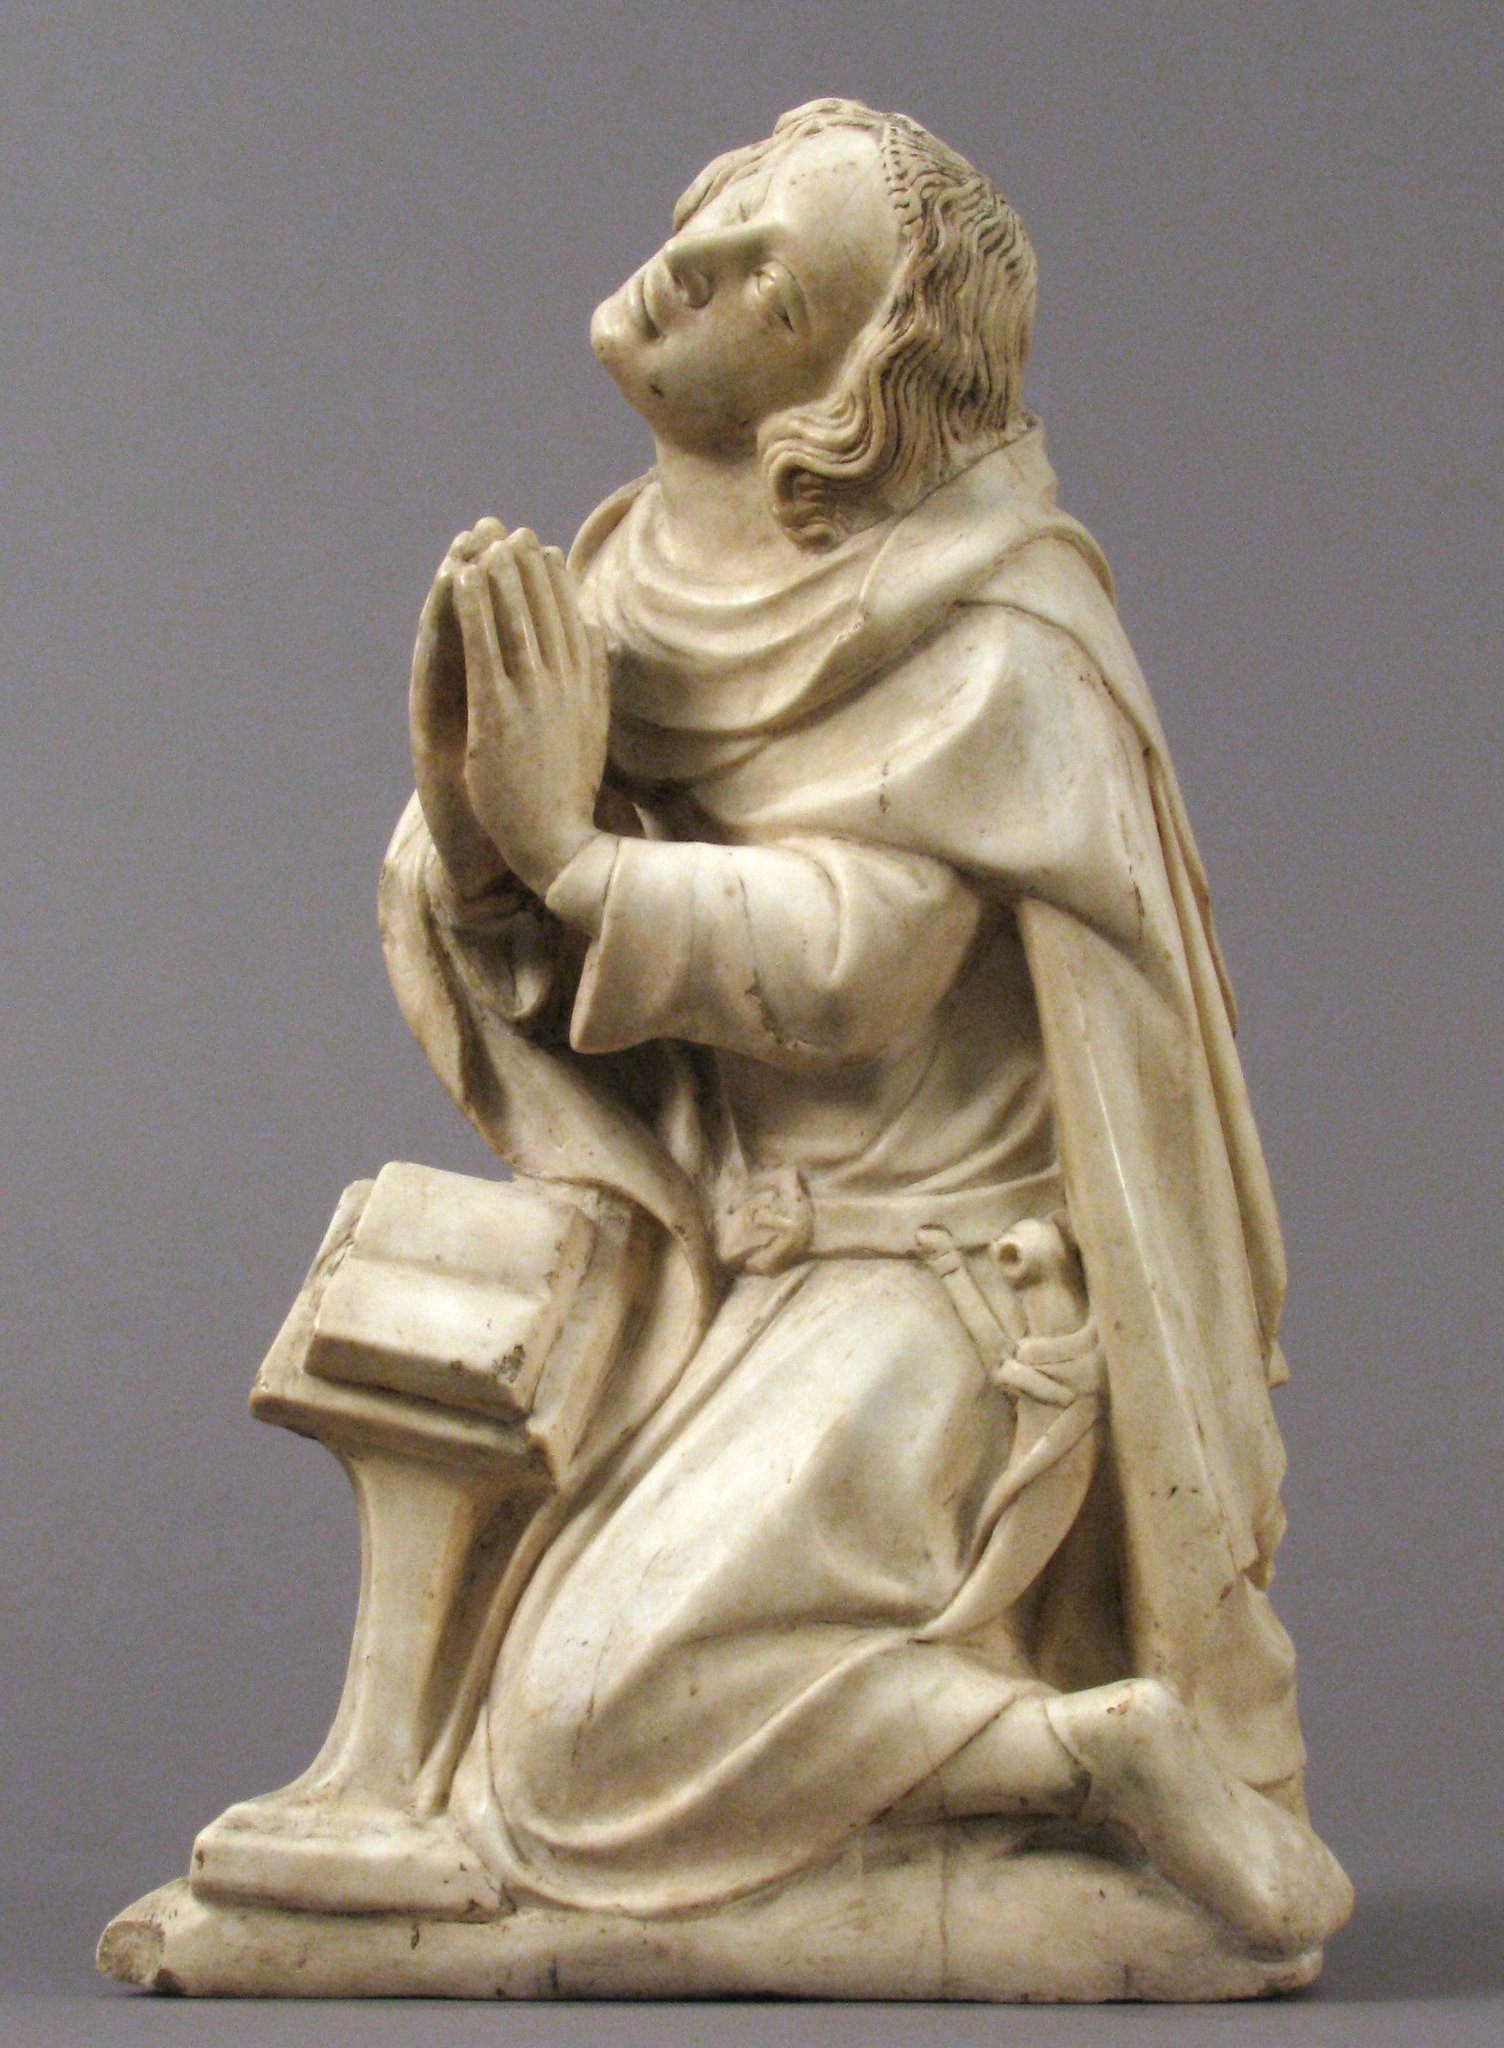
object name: relief statue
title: Saint Elzéar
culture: french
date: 1370-1373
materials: alabaster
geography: france